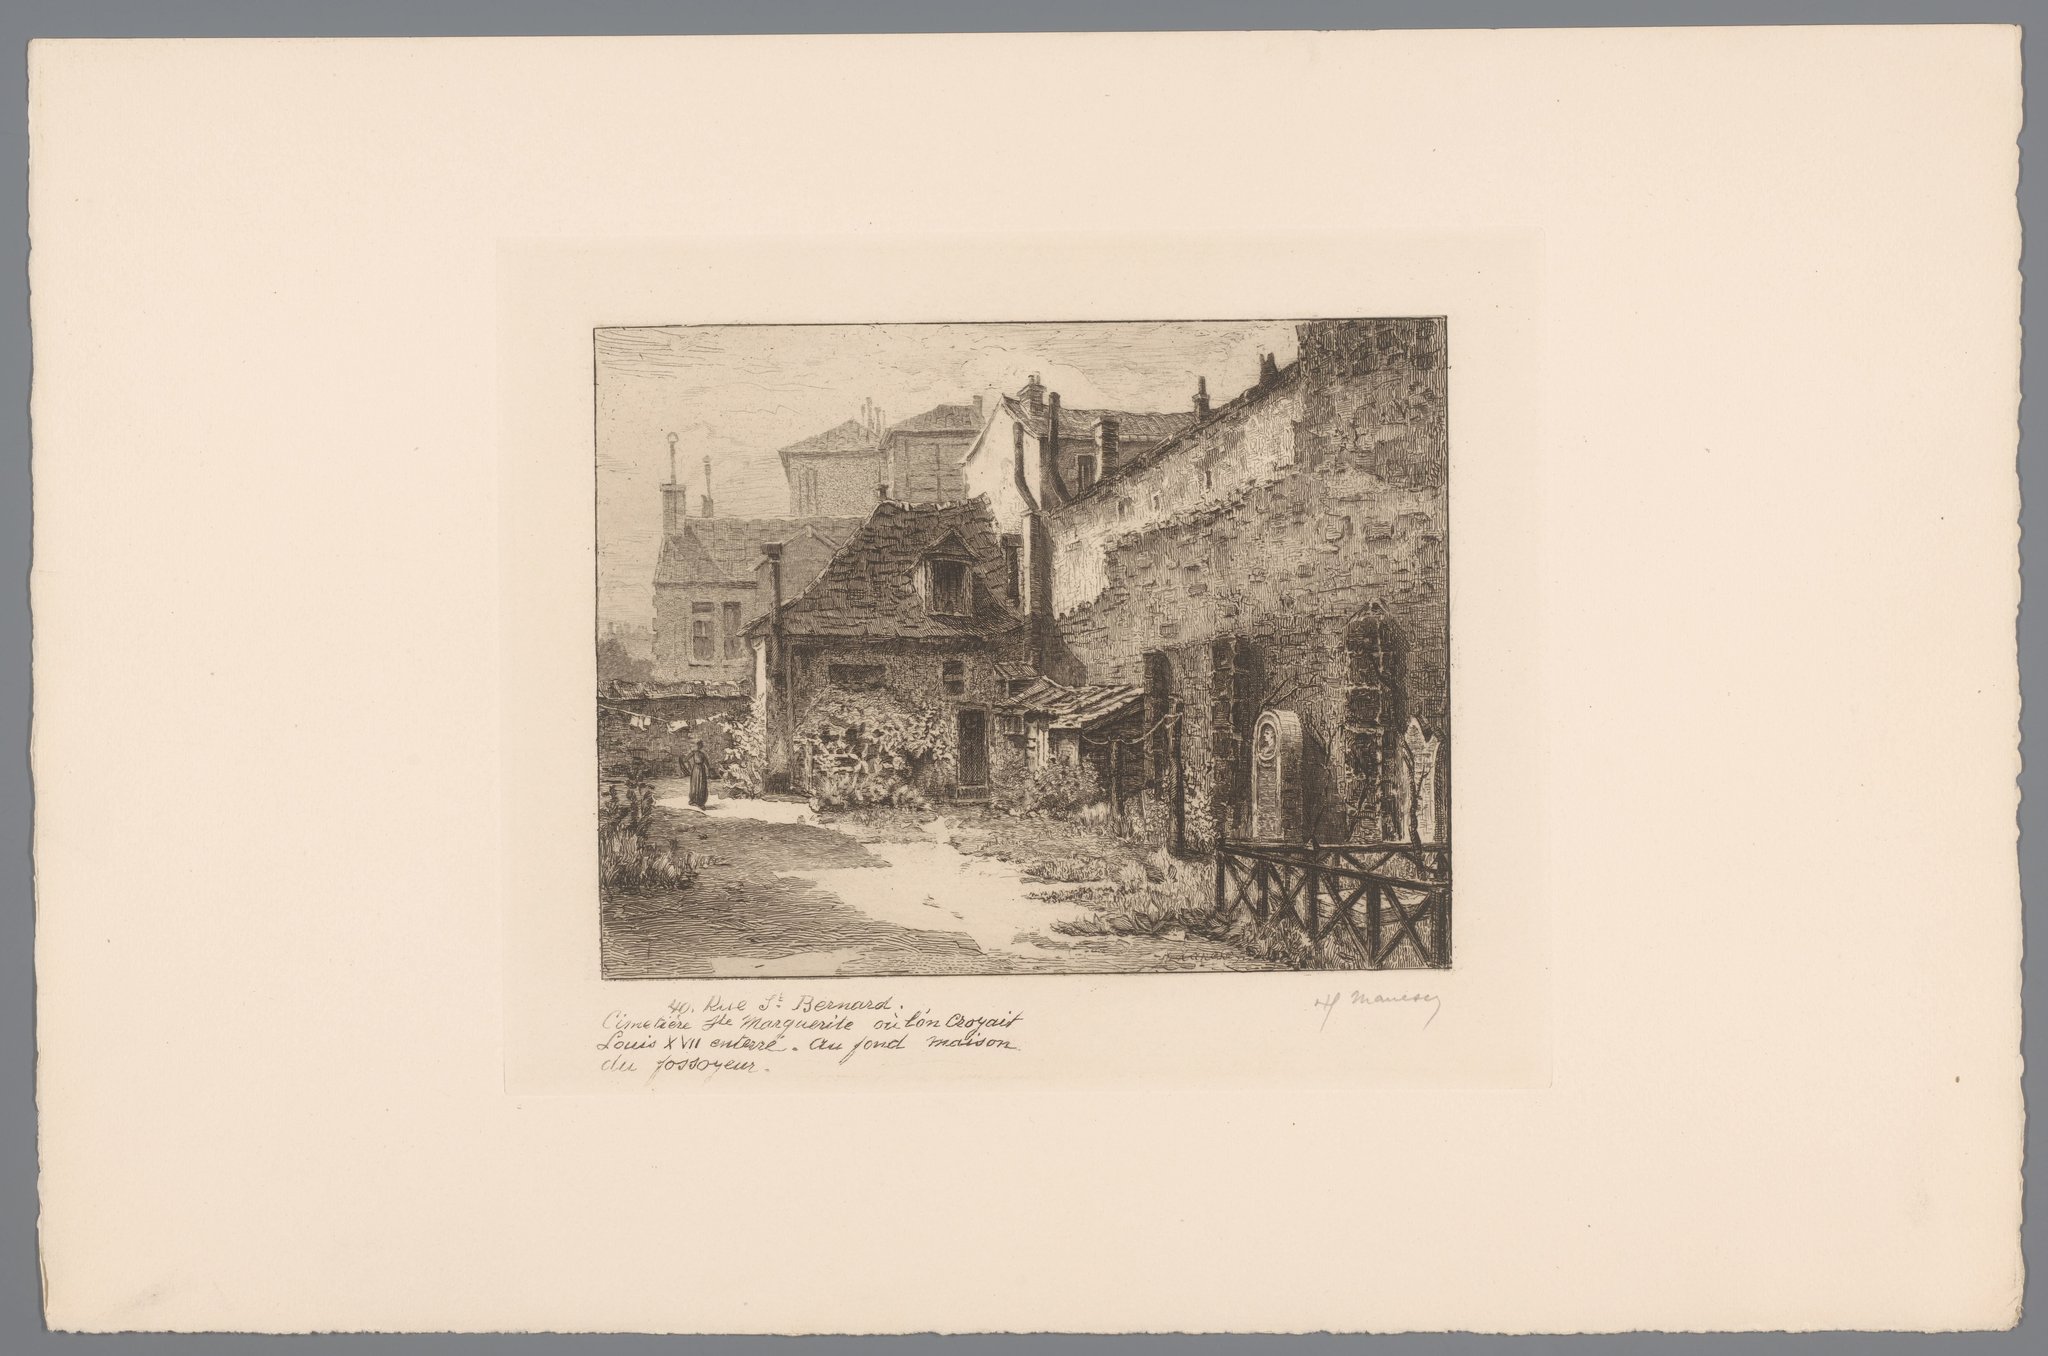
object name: print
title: Gezicht op een begraafplaats in 40 Rue St. Bernard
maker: henri manesse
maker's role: print maker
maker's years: 1854-1940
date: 1906-1911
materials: paper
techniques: drypoint, engraving, etching, intaglio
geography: france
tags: cemetery, park-like burying ground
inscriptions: collector's mark: Lugt 2228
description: Dit is de elfde serie uit een prentreeks die uit minstens elf series bestaat.